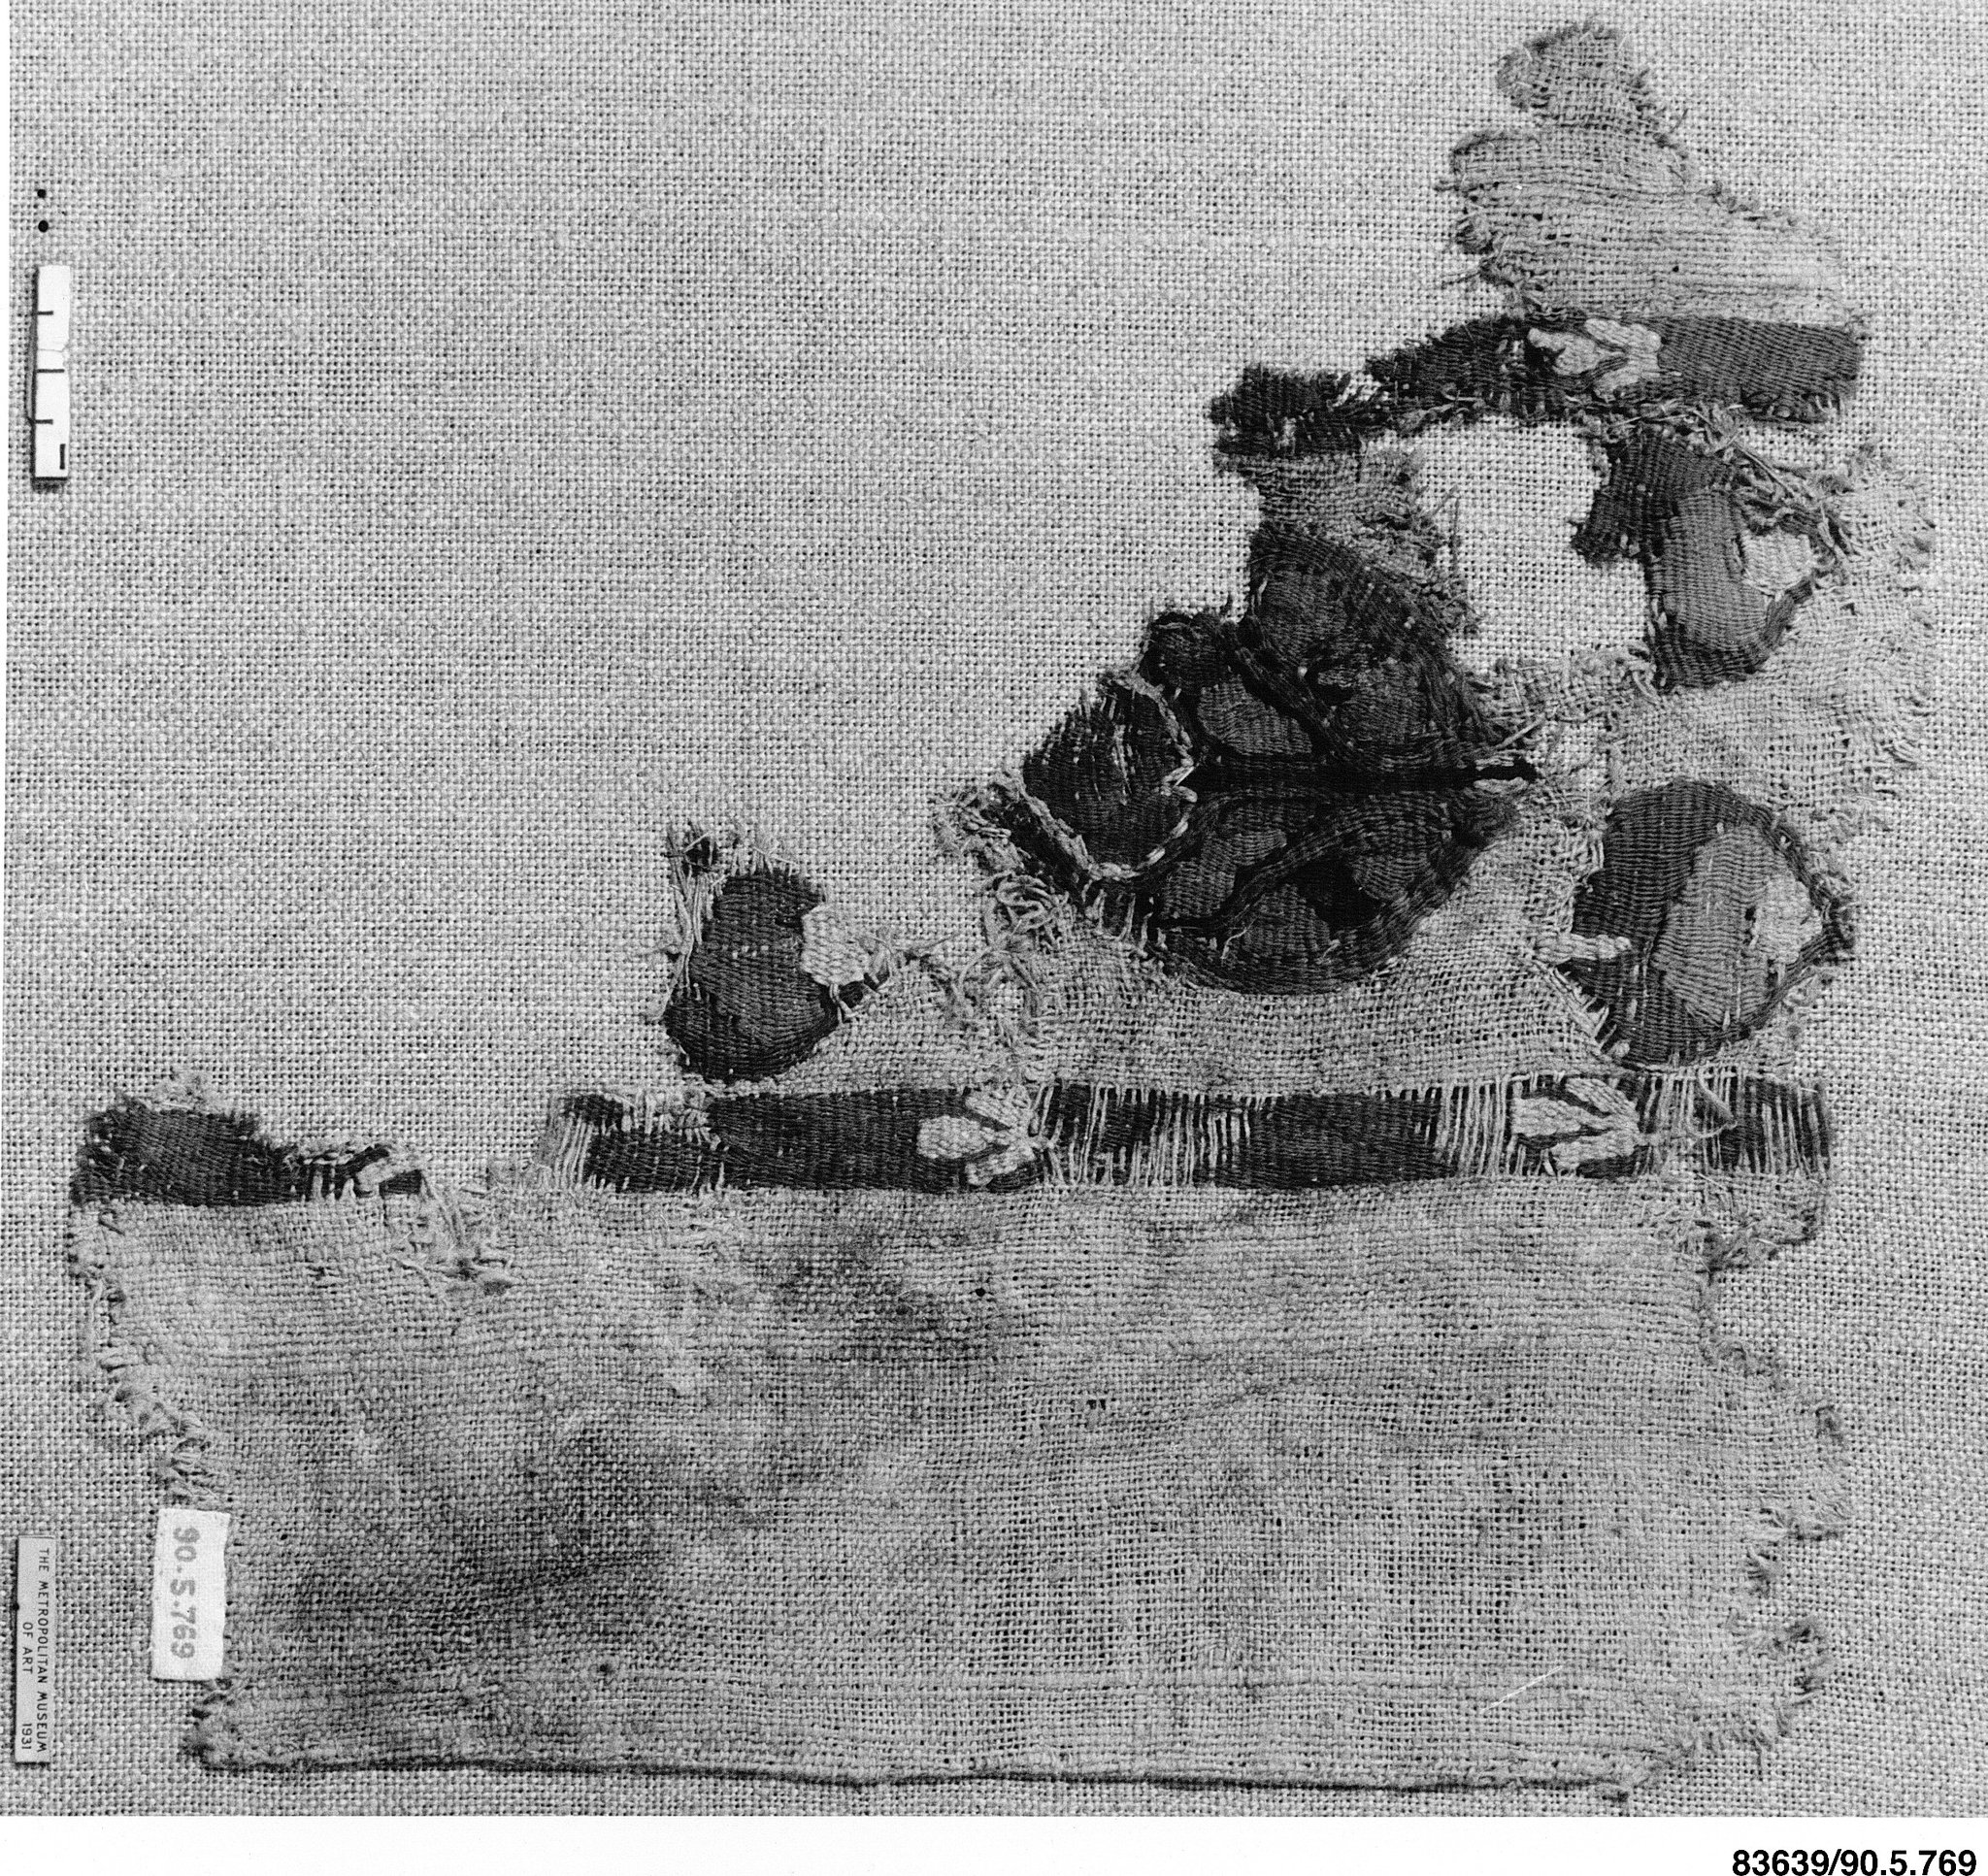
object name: textile fragment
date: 401-600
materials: linen, wool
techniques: weave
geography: egypt